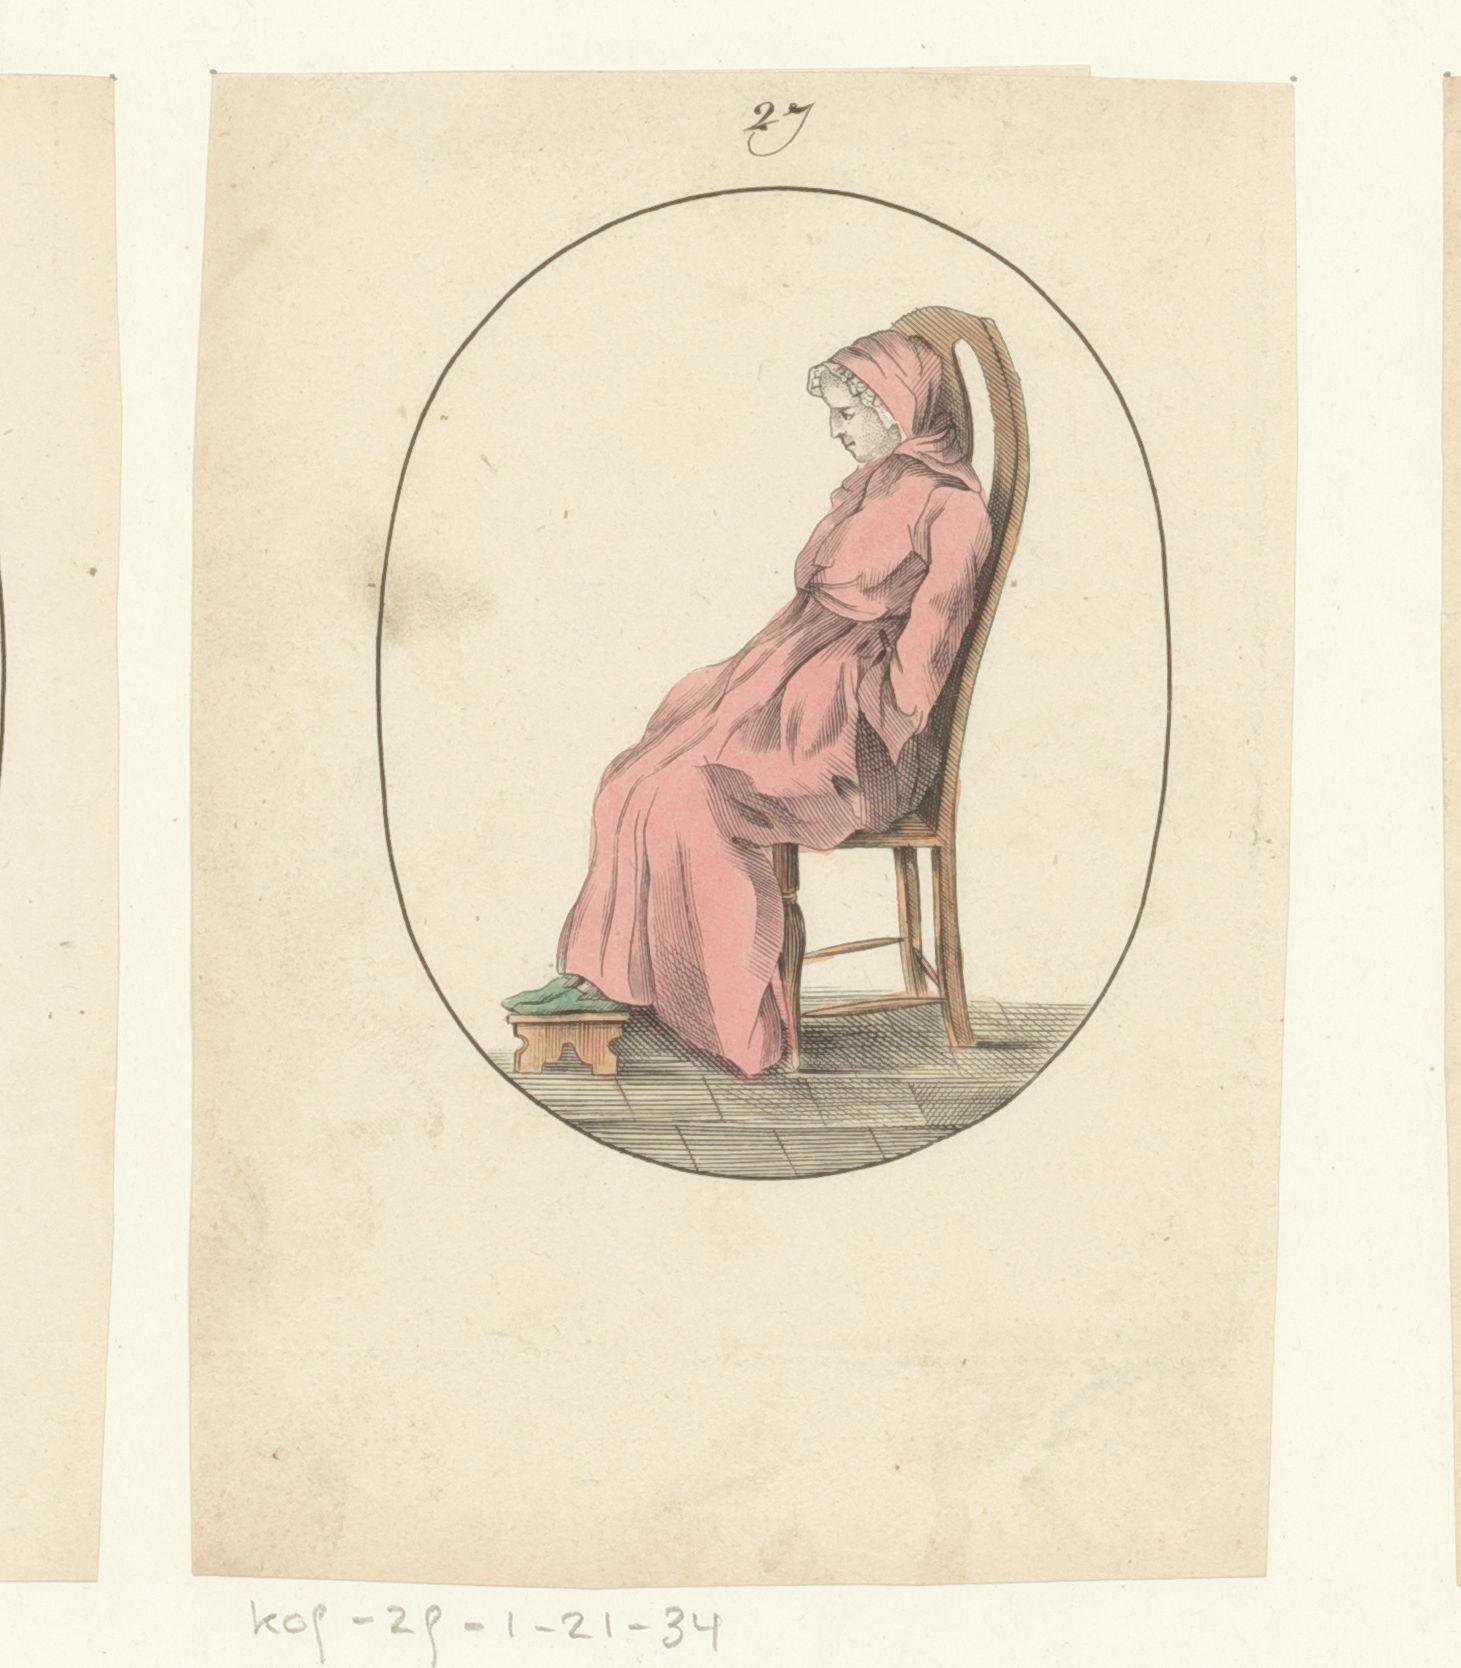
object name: print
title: Zittende vrouw met voeten op een stoof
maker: Anonymous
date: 1750-1849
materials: paper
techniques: etching, hand coloring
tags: sitting on an elevation - aa - female human figure (+ three-quarter view), foot-stove, old woman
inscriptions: collector's mark: Lugt 1641a, collector's mark: Lugt 1641, stamp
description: Bovenaan genummerd: 27. Onderwerpsrubrieken binnen de Atlas Zeden en Gewoonten: Zeden en Gewoonten in Engeren Zin, De Kleeding, Kleederdrachten (tijdvakken), De 18de eeuw (de pruikentijd). Mannen en vrouwen.